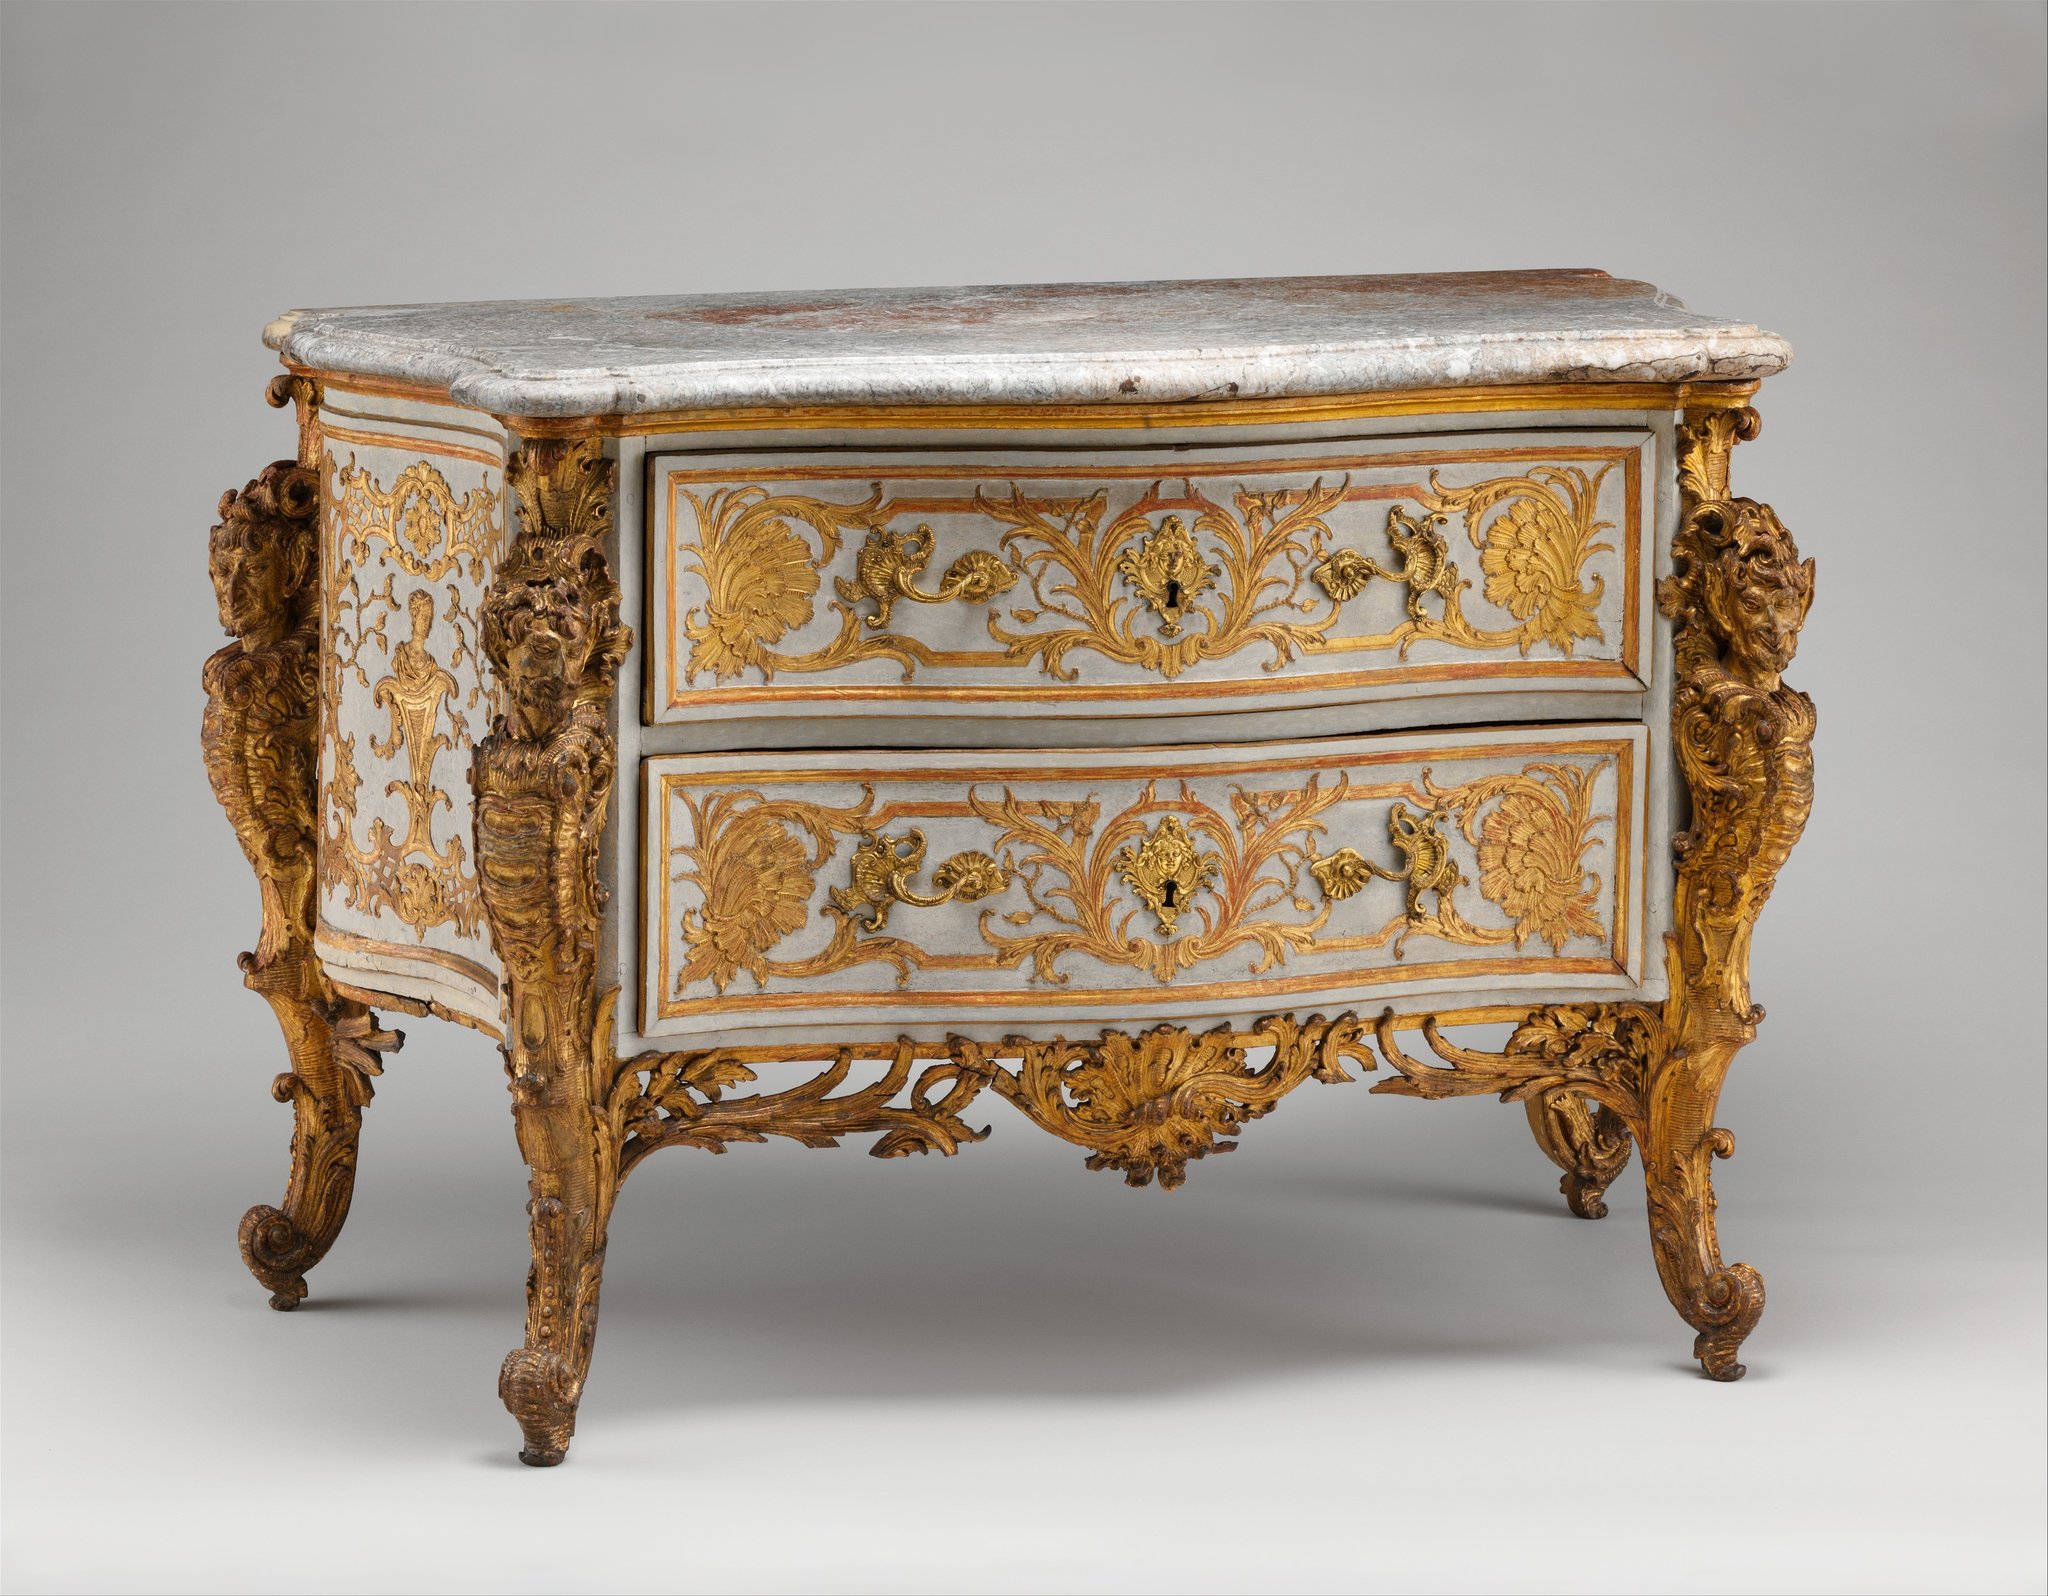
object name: commode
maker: jean françois cuvilliés the elder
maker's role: designer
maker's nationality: german, born belgian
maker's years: 1695-1768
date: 1735-1740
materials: gesso, limestone, wood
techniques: carving, gilding, incising, painting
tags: satyrs